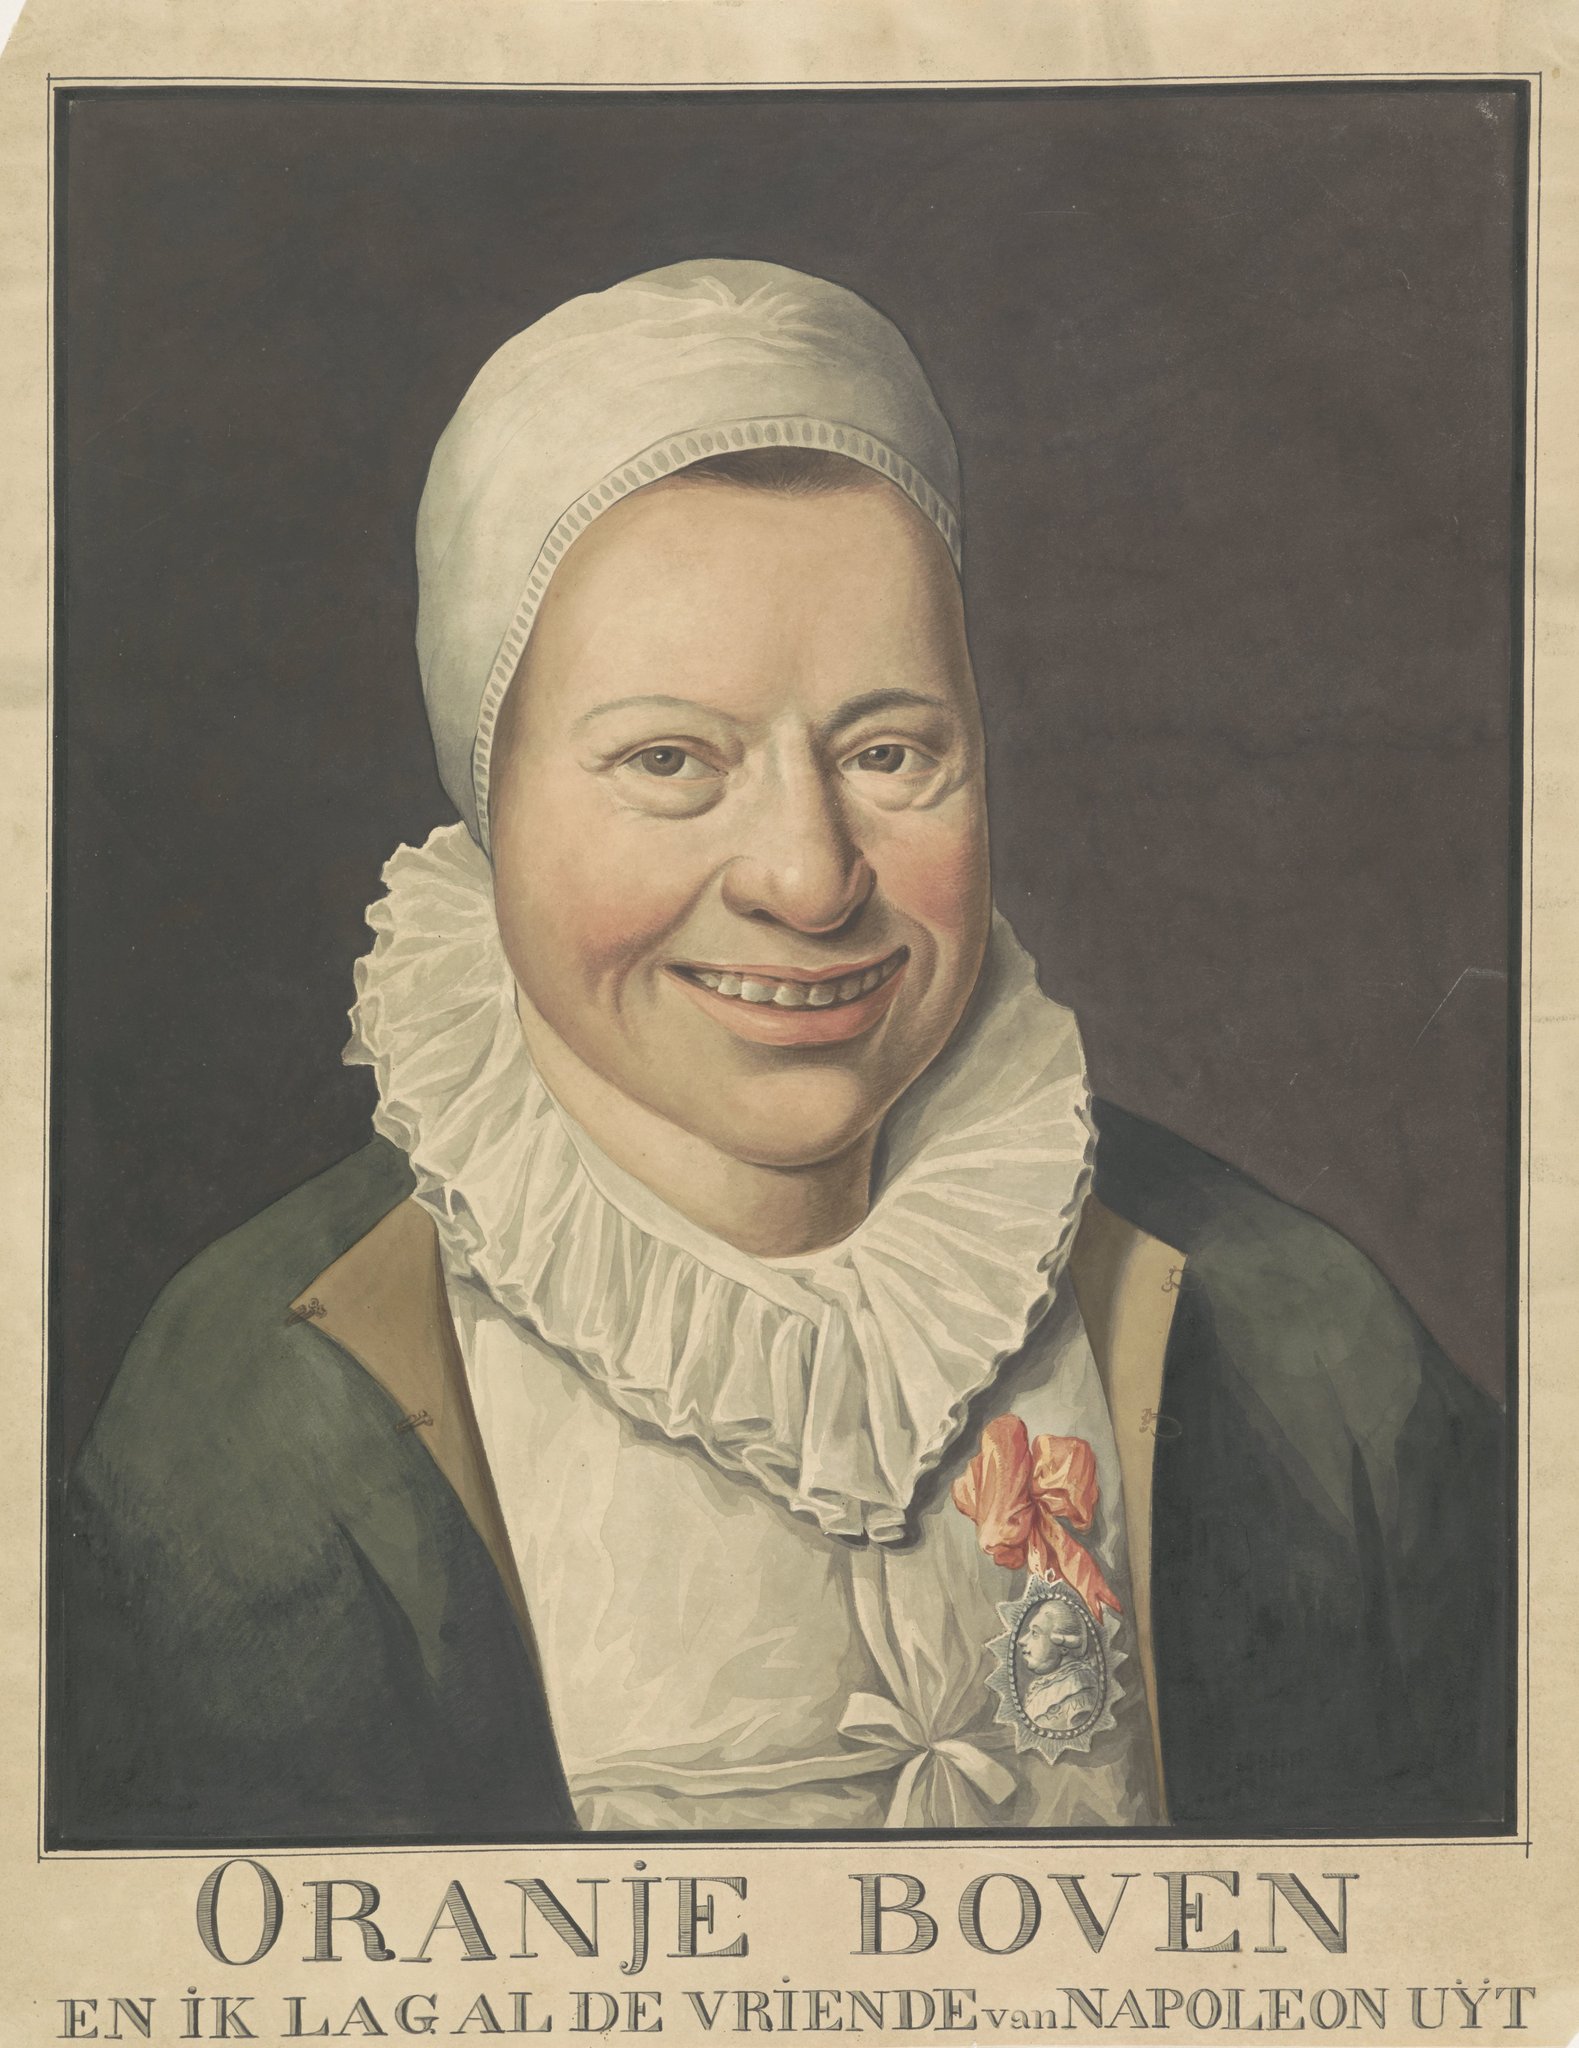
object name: drawing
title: Oranje Boven en ik lag al de vriende van Napoleon uyt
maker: Anonymous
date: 1813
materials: paper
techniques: brush, pen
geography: netherlands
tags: william v (prince of orange), berlin, william i of the netherlands, napoleon i (emperor of the french), laughing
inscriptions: collector's mark: Lugt 2228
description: Portret van een lachende prinsgezinde vrouw, naar aanleiding van de bevrijding van Nederland in 1813. De vrouw draagt een muts en op de borst een medaillon van prins Willem V aan een oranje lint. Volgens overlevering zou het gaan om een dienstbode van de familie Simon Thomas te Leiden.